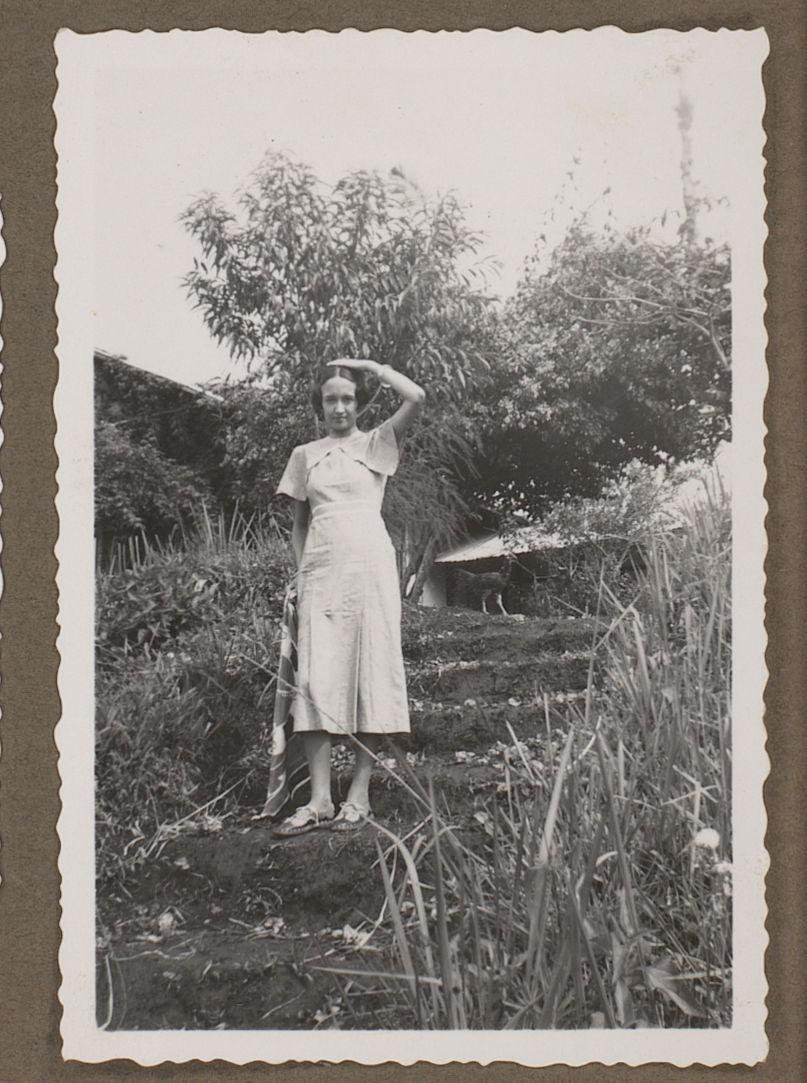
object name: photograph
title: Portret van Dootje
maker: Anonymous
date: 1934-1935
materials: paper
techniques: gelatin silver print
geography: dutch east indies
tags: historical persons - bb - woman, hand(s) bent towards the head, dutch east indies, the